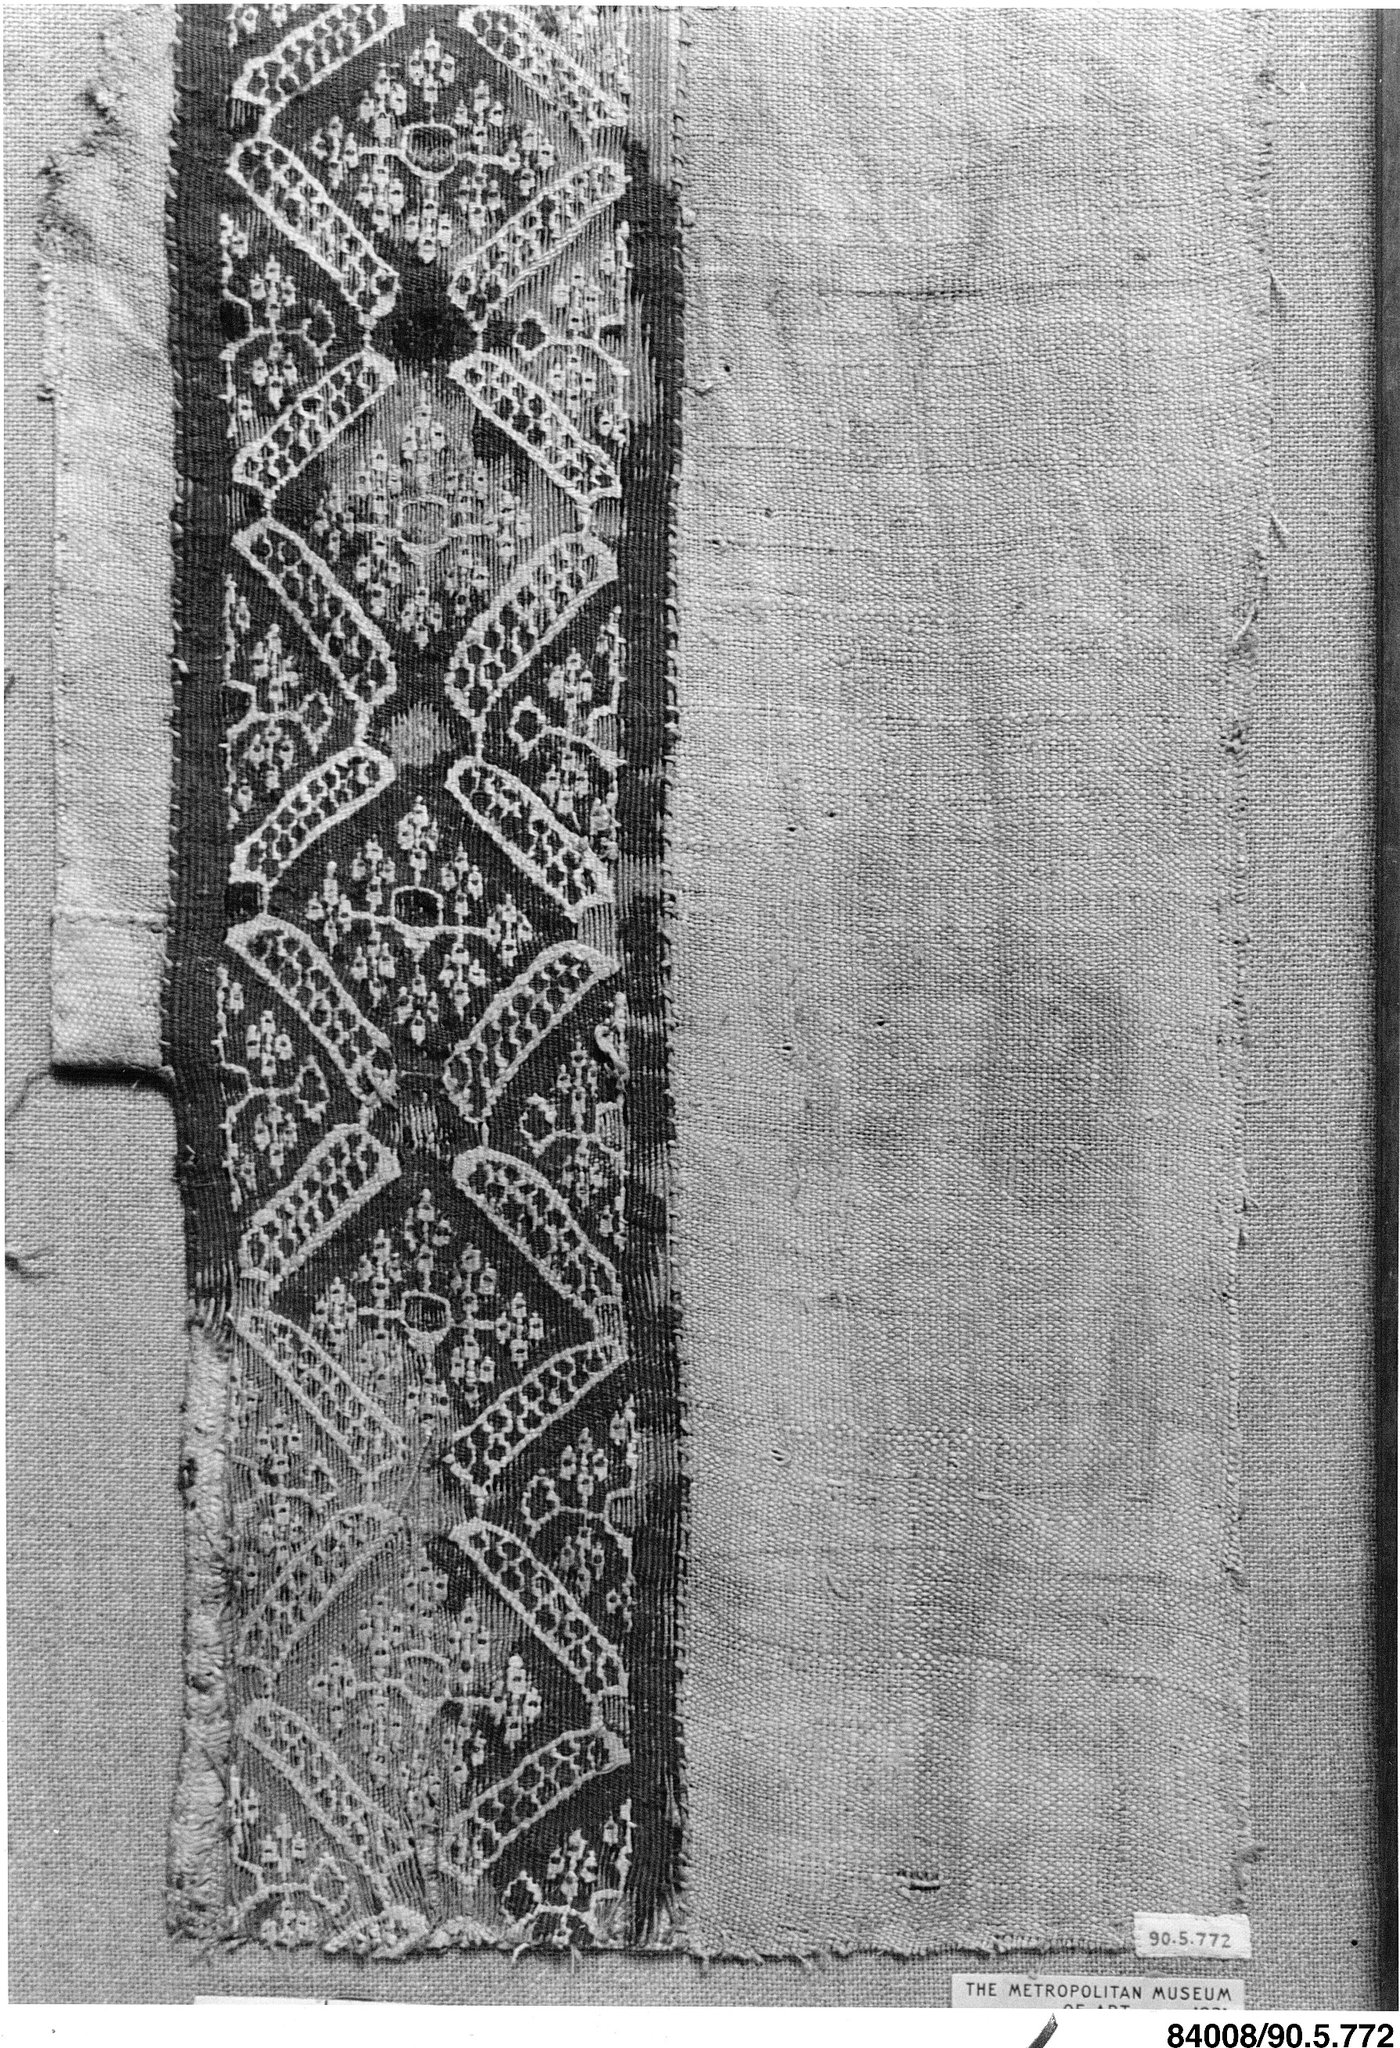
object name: textile fragment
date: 501-700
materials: linen, wool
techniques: weave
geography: egypt